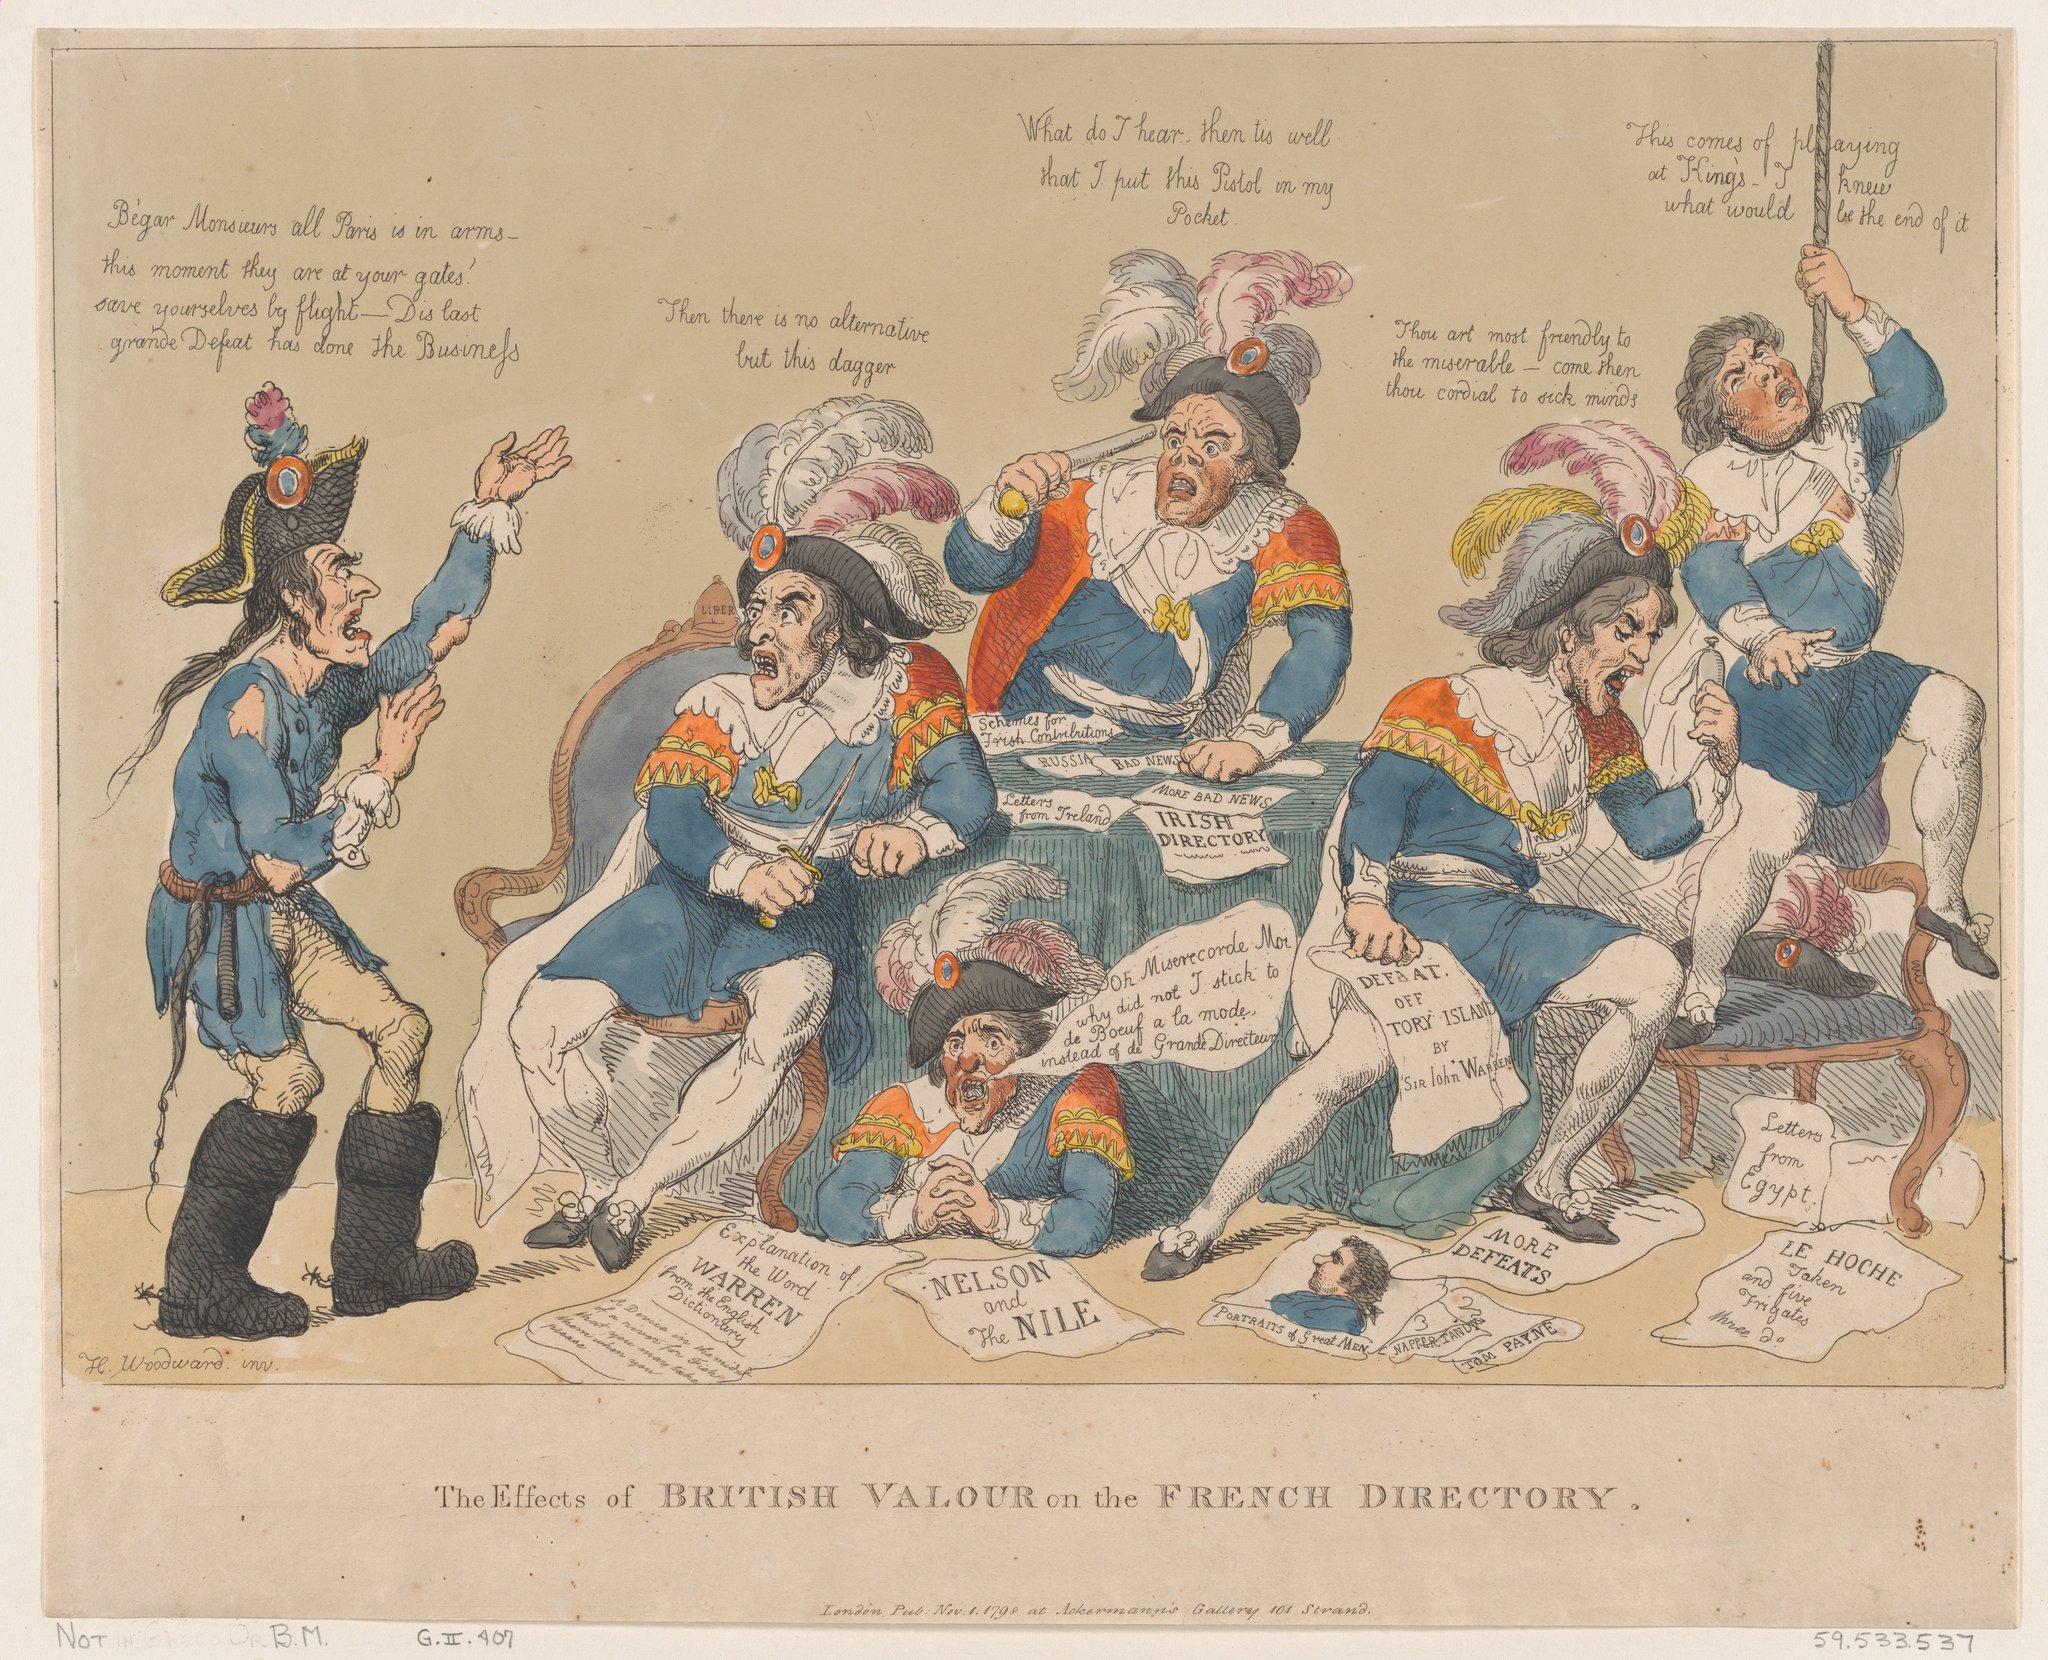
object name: print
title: The Effects of British Valour on the French Directory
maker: thomas rowlandson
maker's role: artist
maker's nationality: british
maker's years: 1757-1827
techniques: aquatint, etching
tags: men,punishment